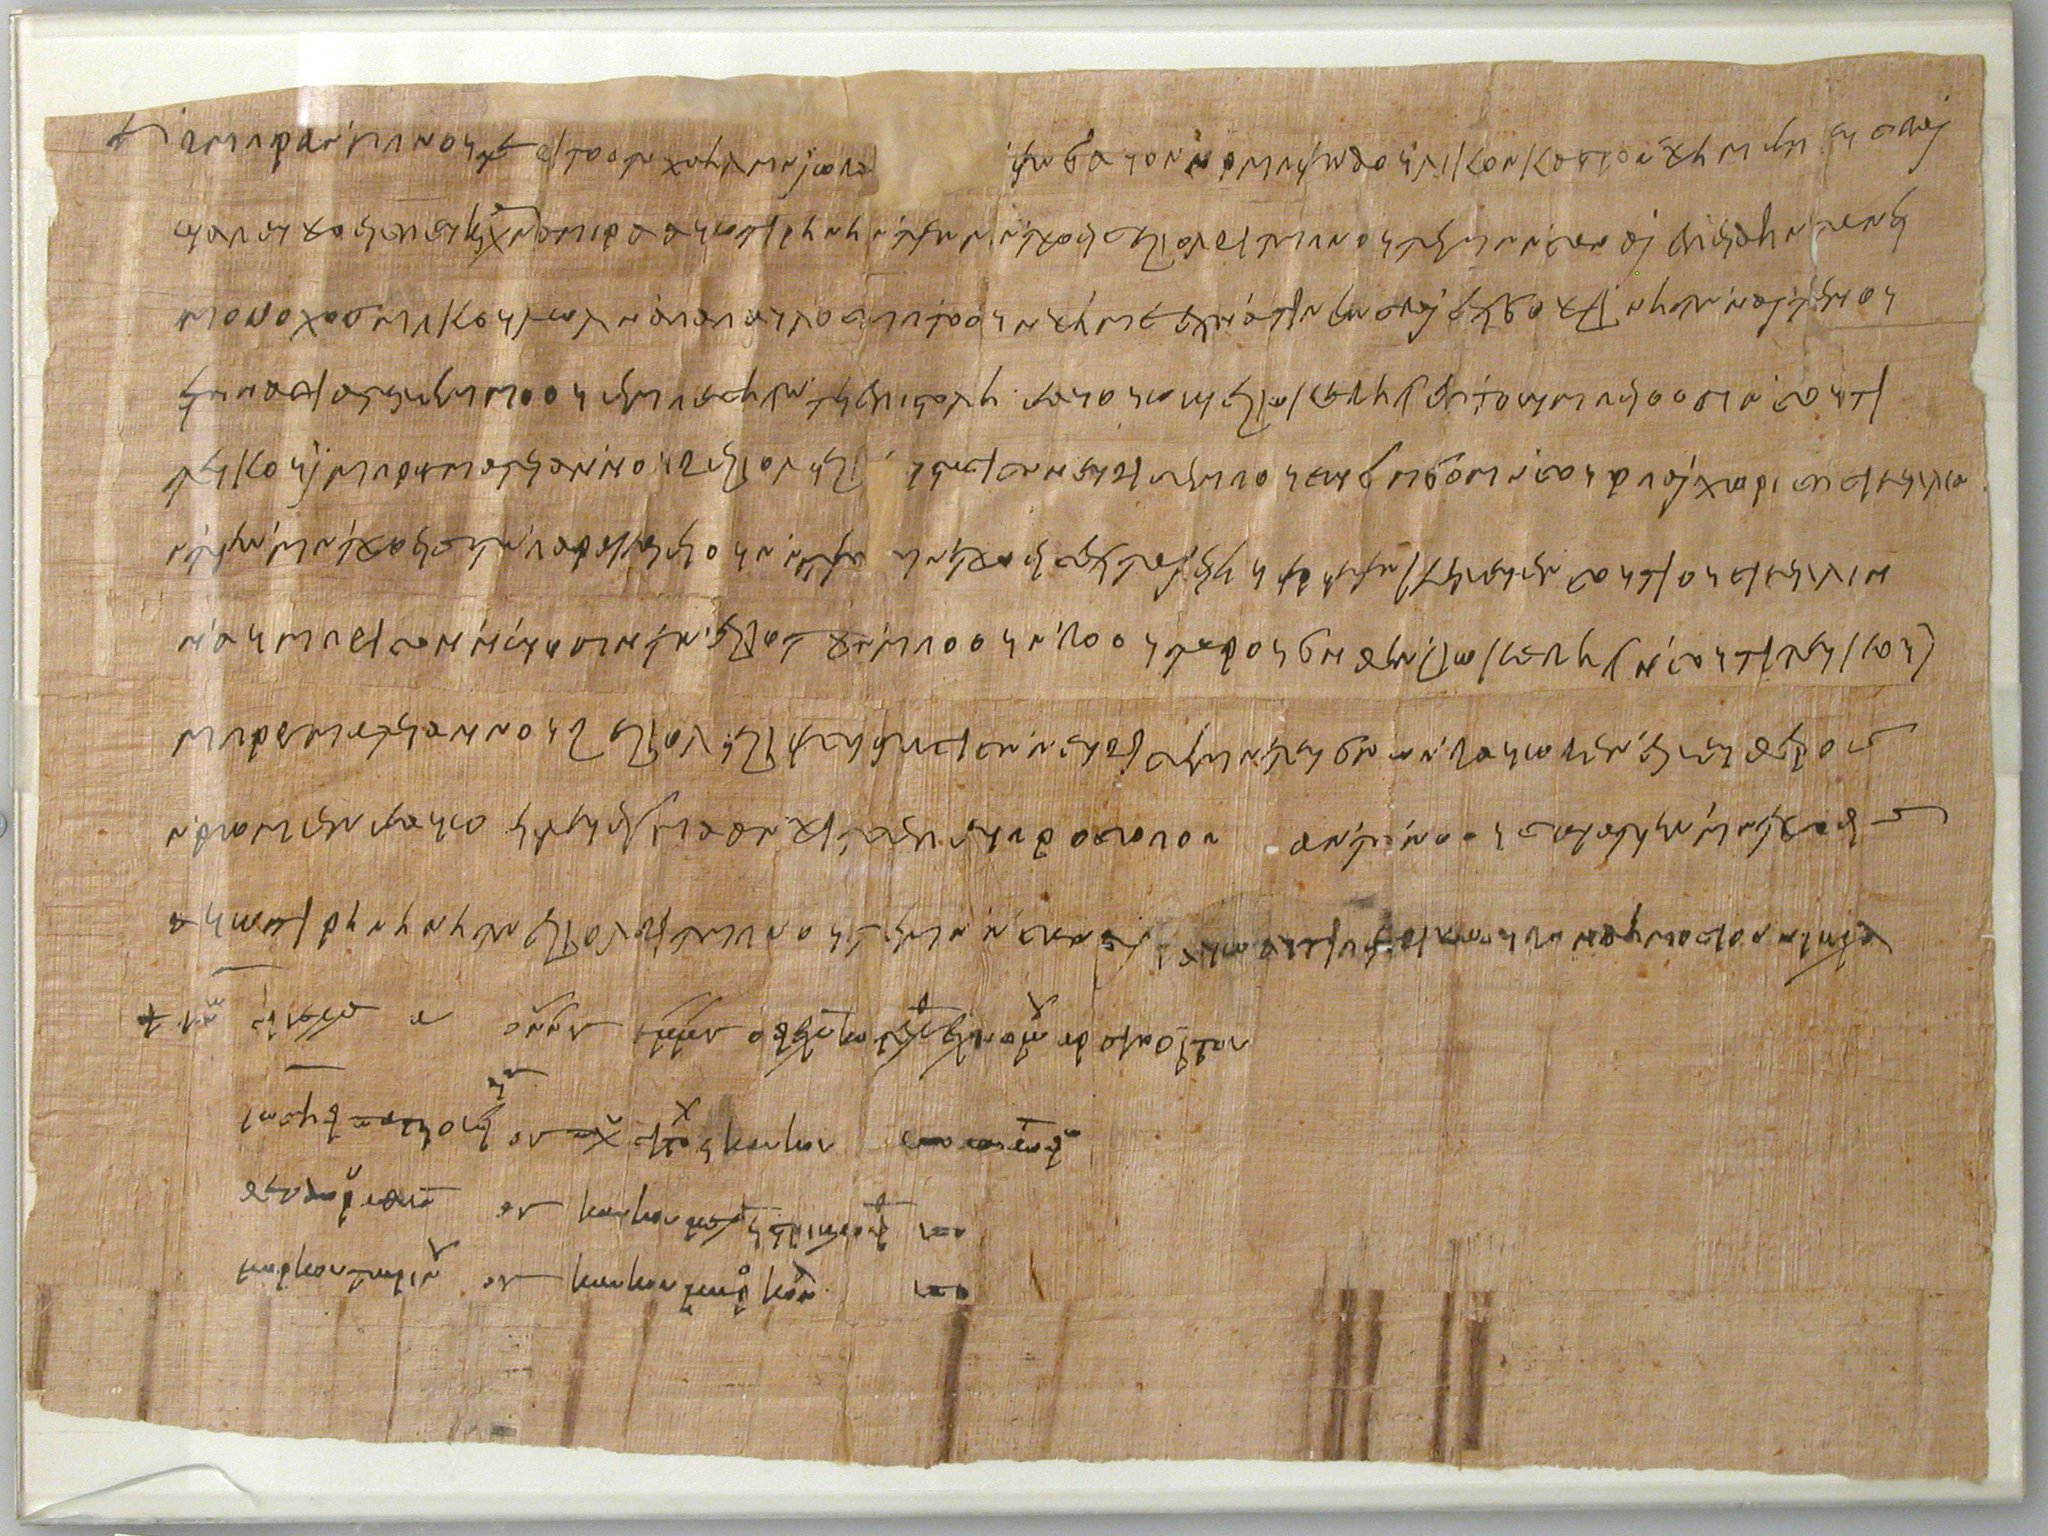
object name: papyrus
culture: coptic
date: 734-766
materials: ink, papyrus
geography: egypt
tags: documents